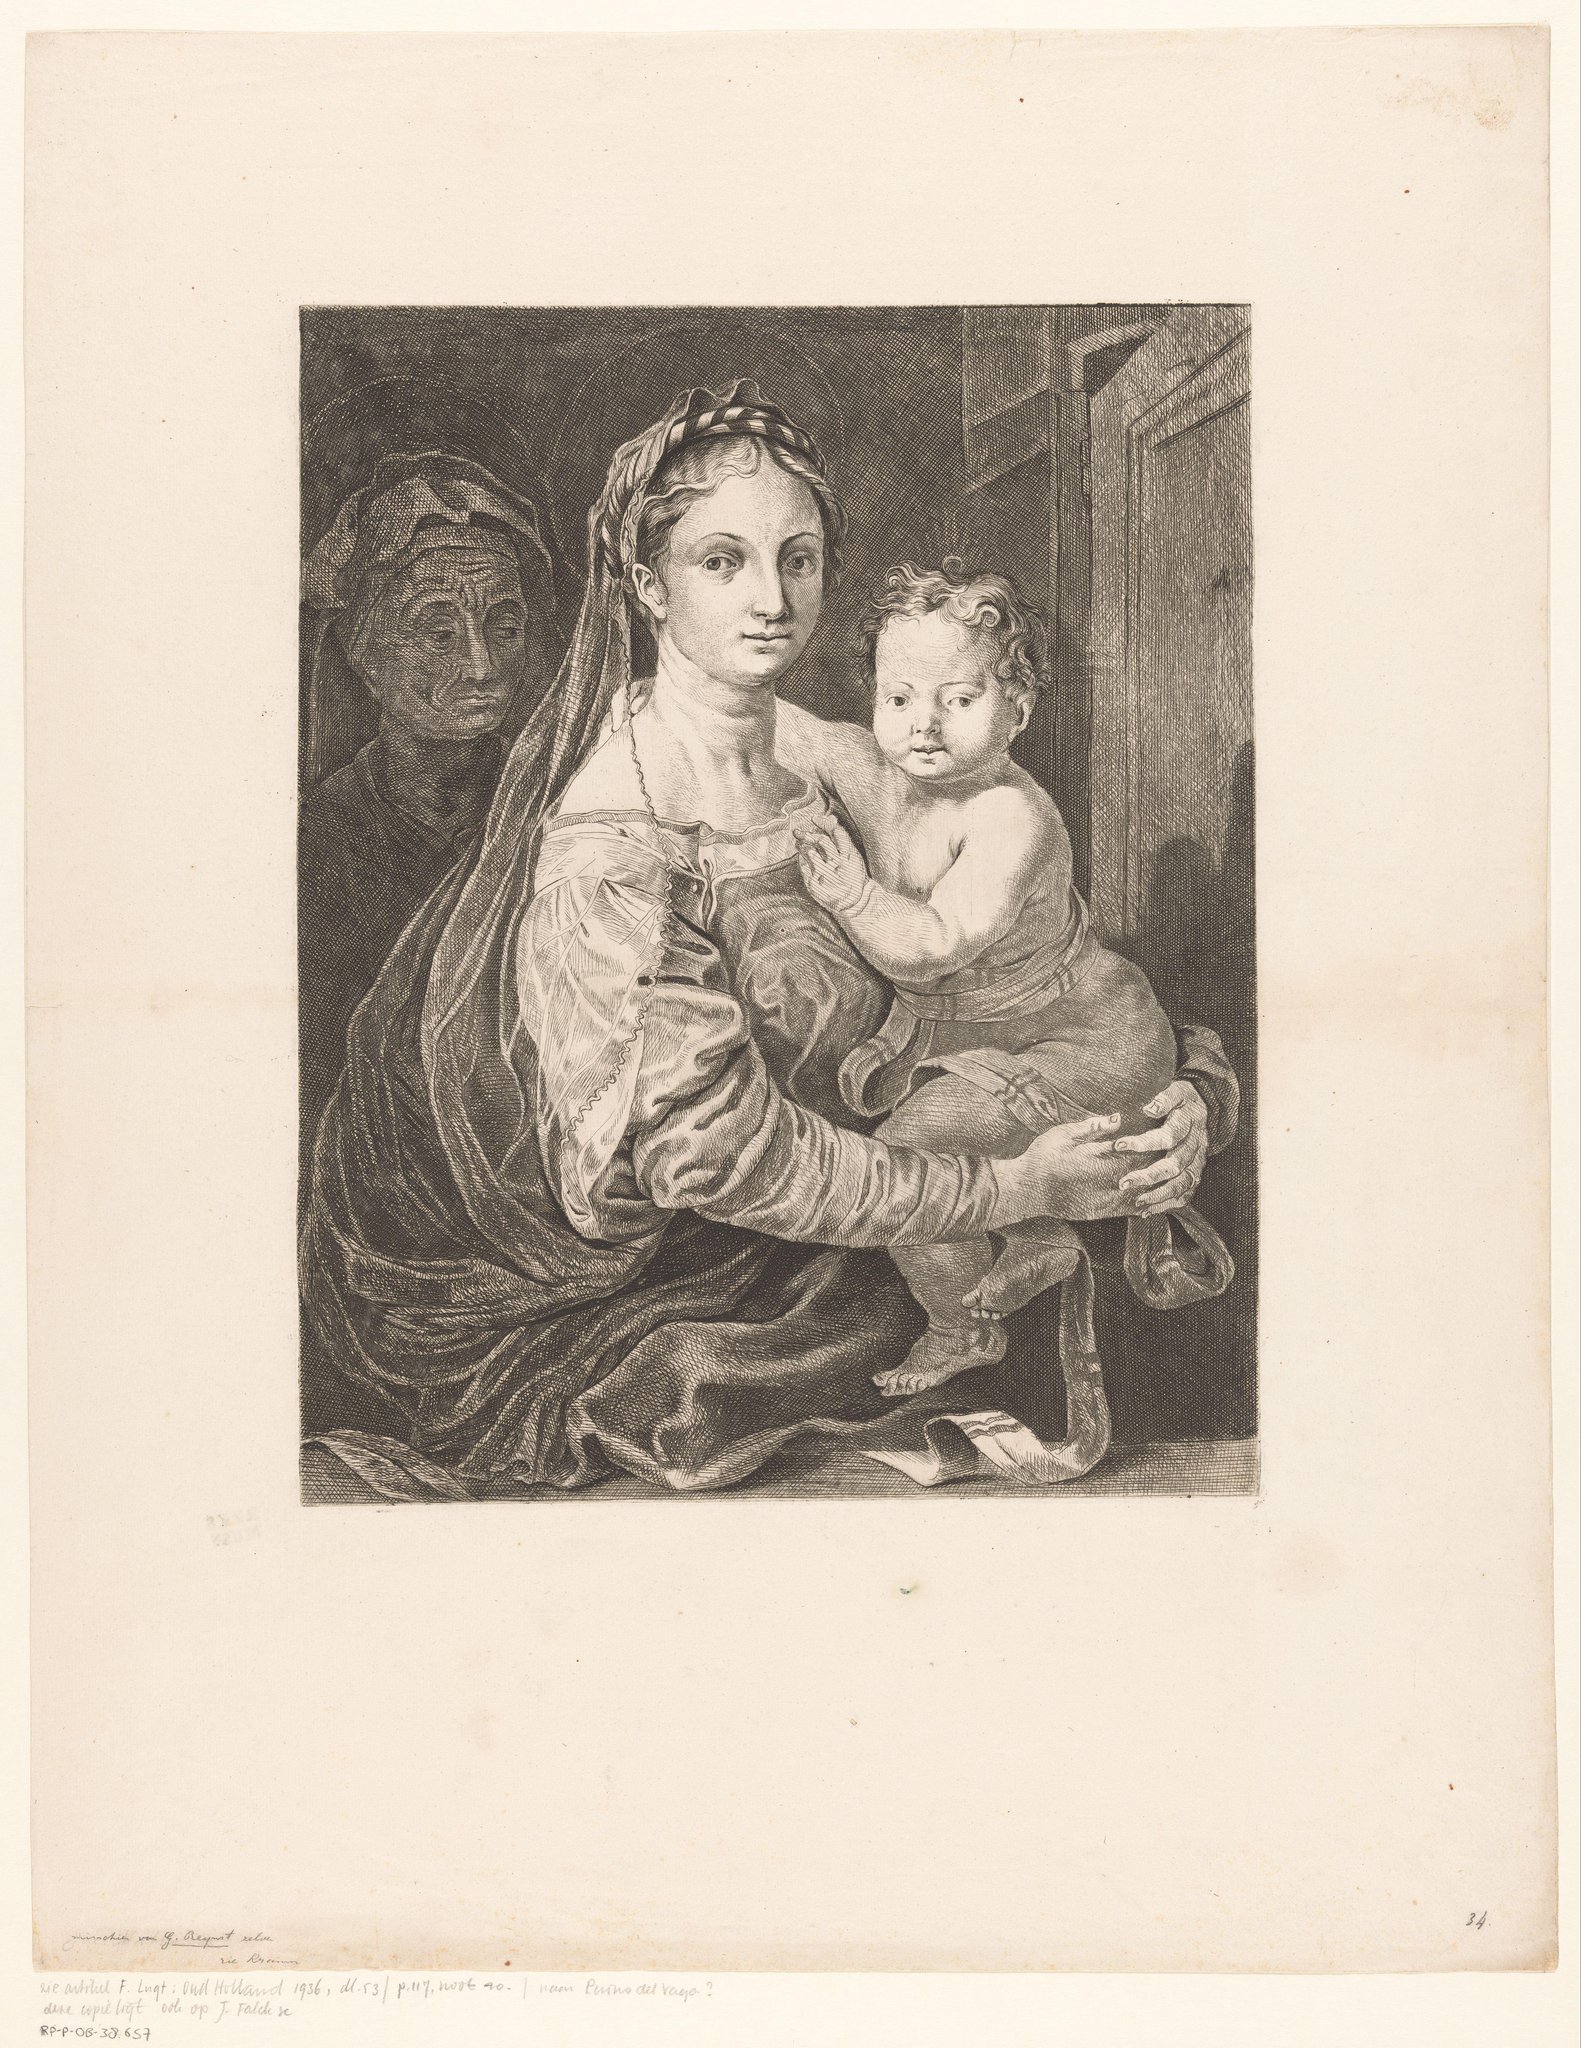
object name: print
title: Maria met Kind en de heilige Anna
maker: Anonymous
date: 1600-1699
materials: paper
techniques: etching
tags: holy family with others, e.g.: anna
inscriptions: collector's mark: Lugt 2165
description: Maria houdt het Christuskind in haar armen. Links staat haar moeder Anna.